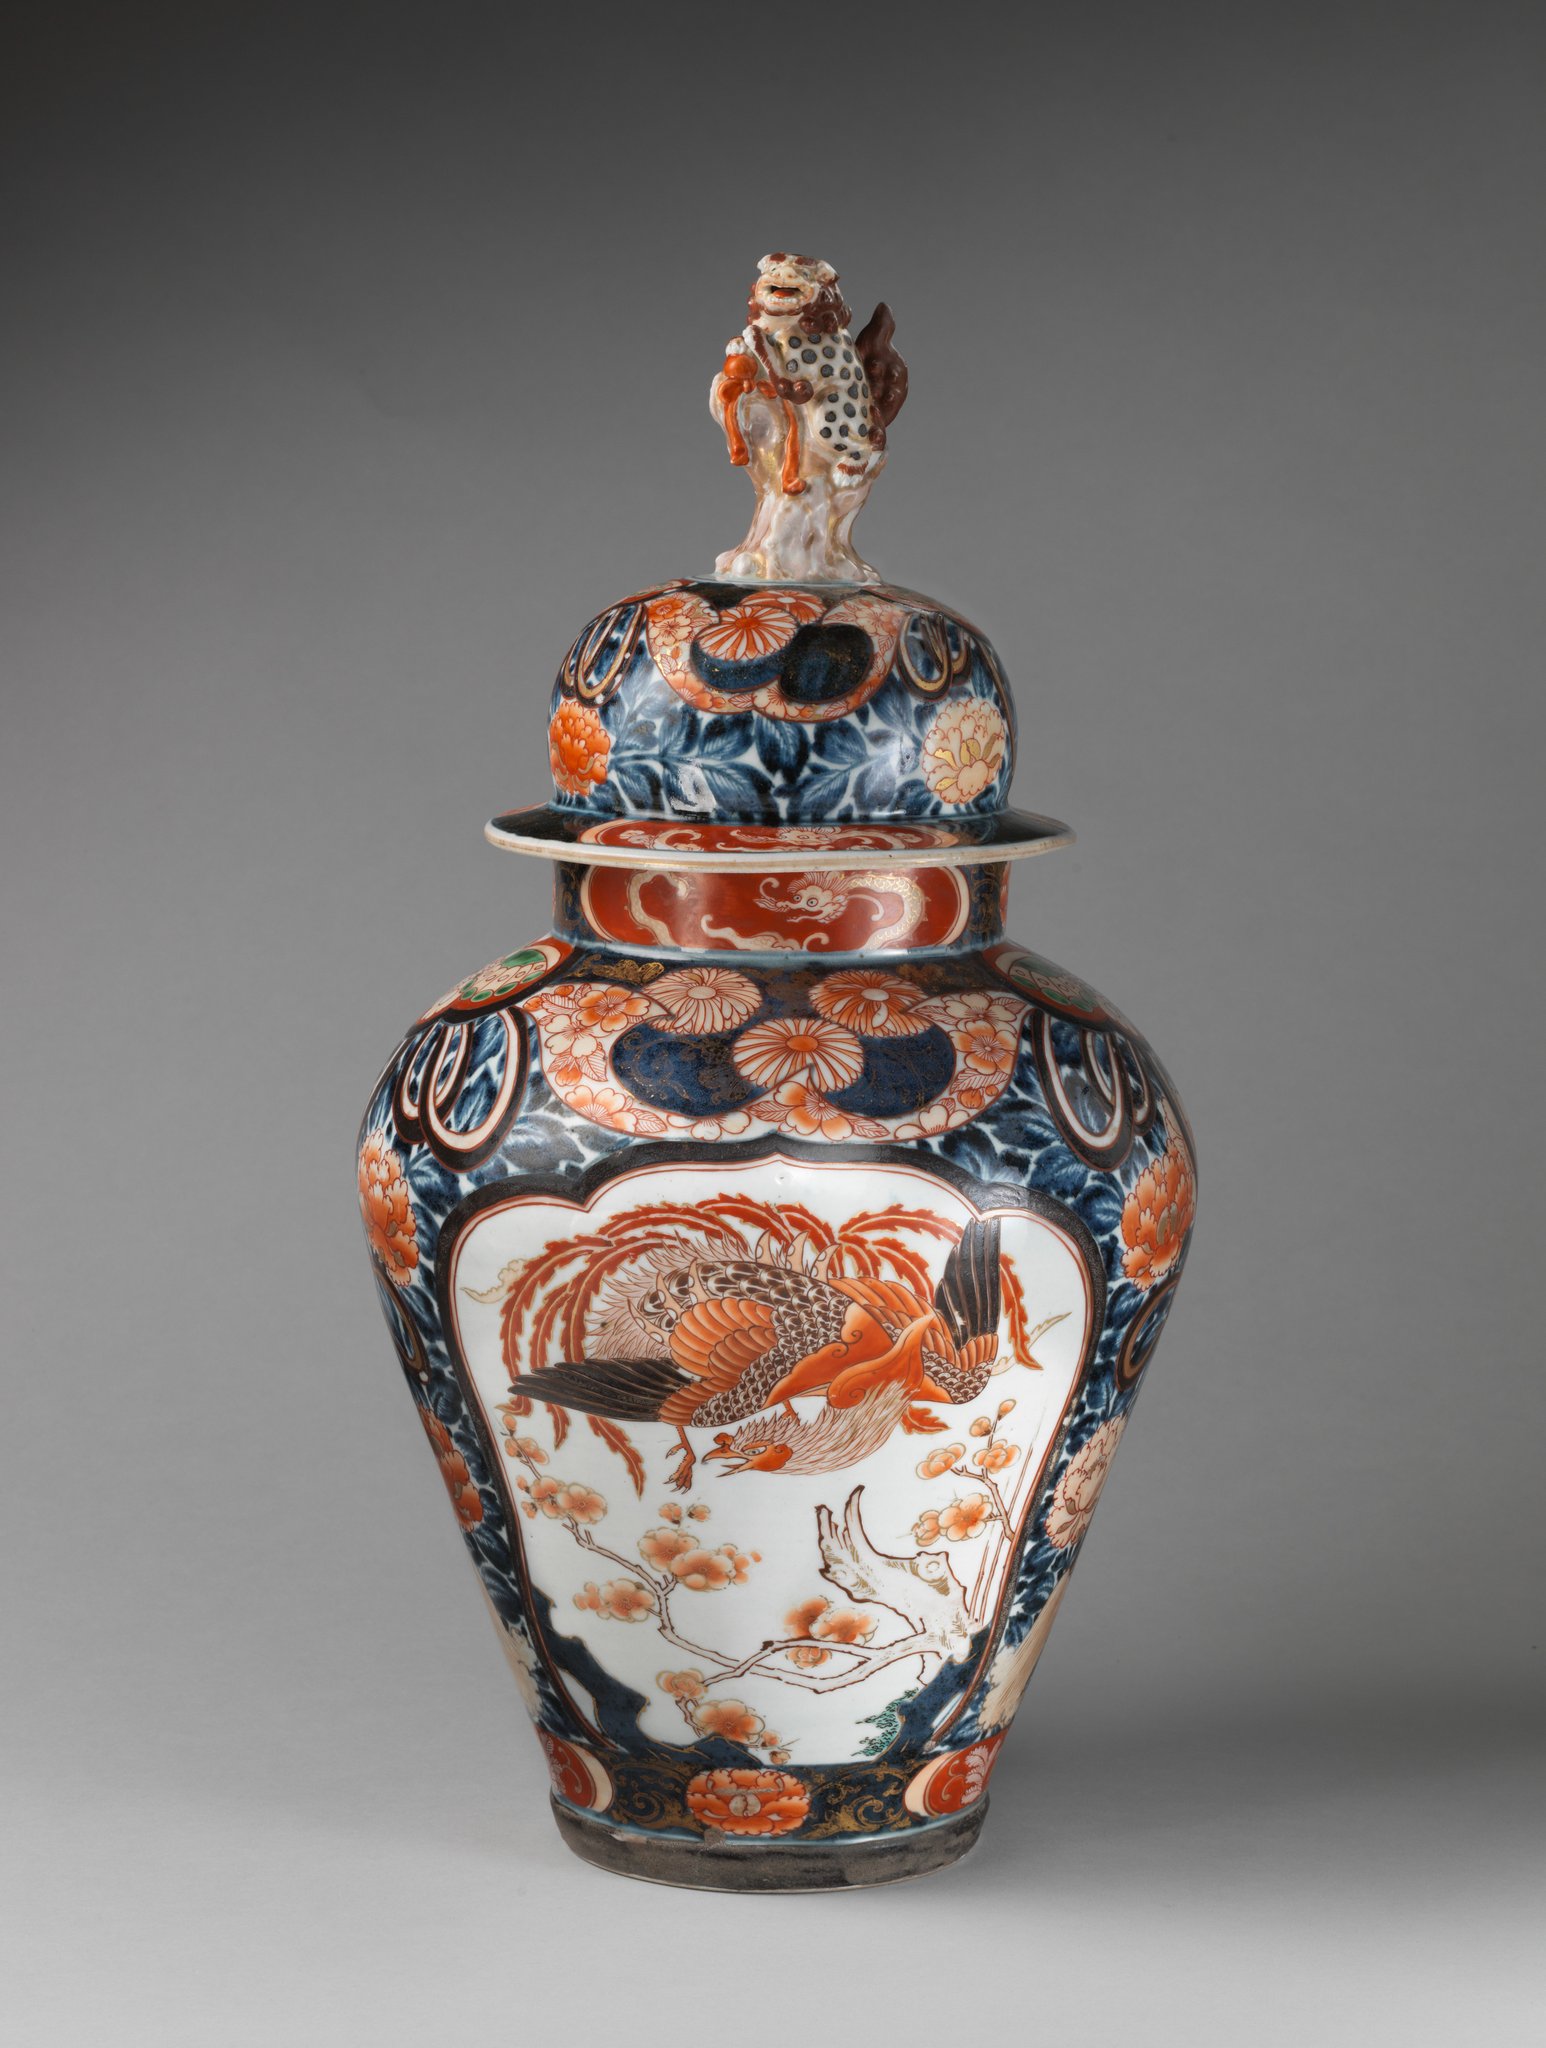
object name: vase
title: Baluster-shaped vase (part of a five-piece garniture)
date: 1690-1720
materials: enamel, hard paste porcelain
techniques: gilding, overglaze, underglaze